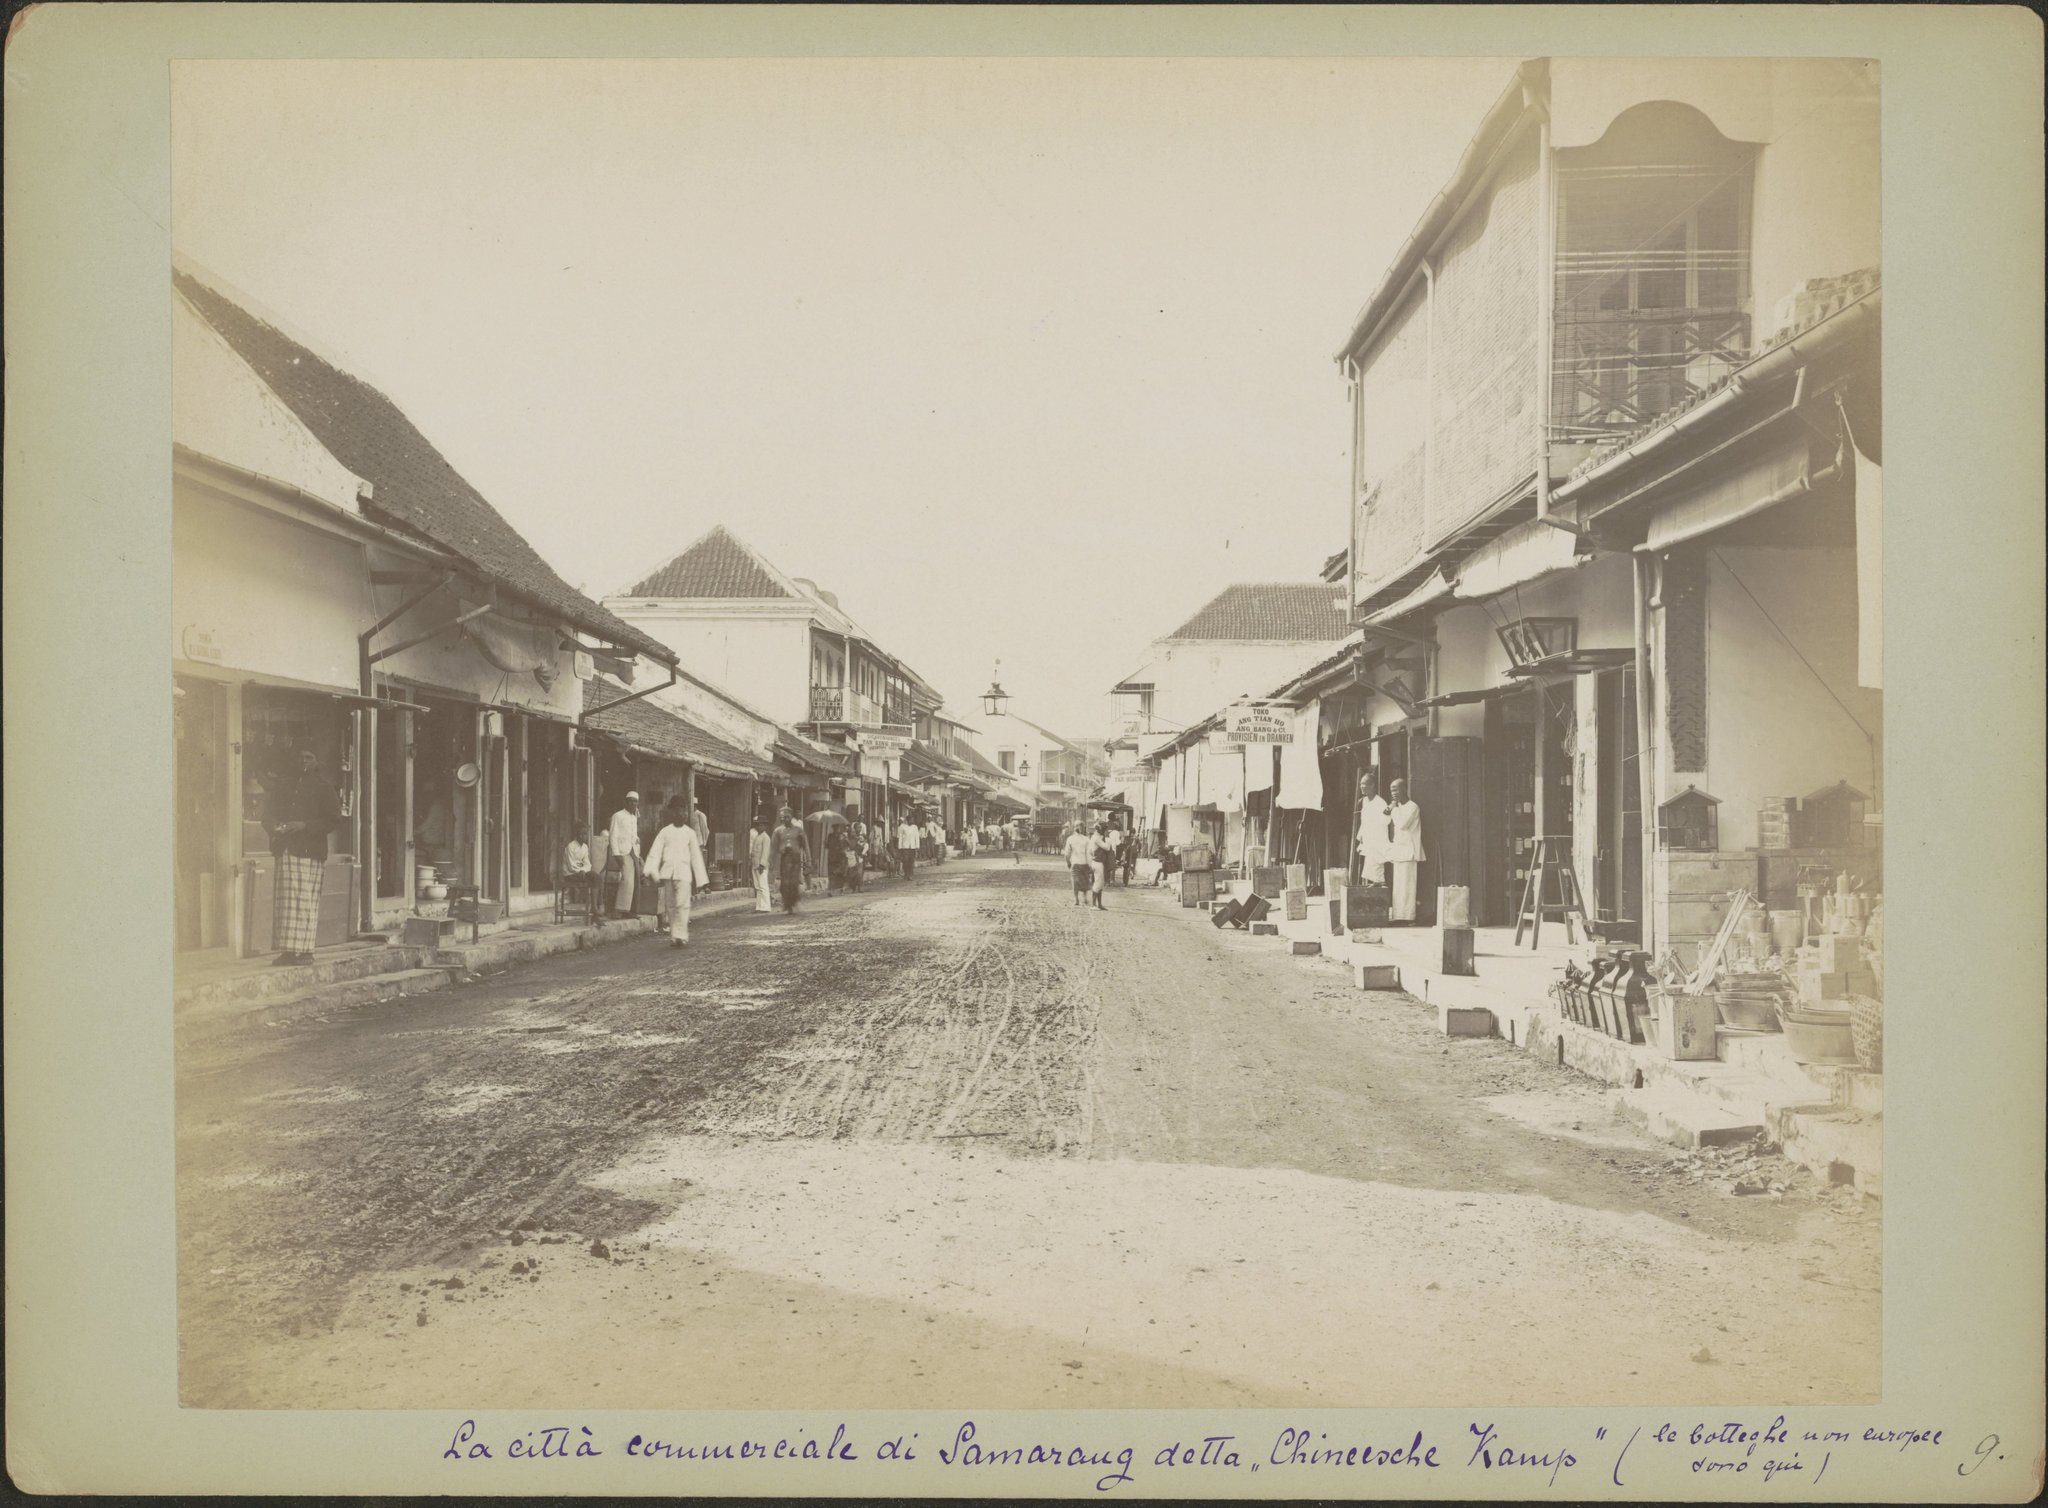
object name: album leaf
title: Straatgezicht in het Chinese kamp te Semarang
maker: Anonymous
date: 1870-1910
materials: cardboard, paper, photographic support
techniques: albumen print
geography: semarang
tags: shop, store, street (+ city(-scape) with figures, staffage)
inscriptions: inscription: ‘Chineesche kamp te Semarang’, inscription: ‘Collezione Maria van Maanen Via Boncompagni 93 Roma’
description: Onderdeel van Reisalbum met foto's van bezienswaardigheden in Marseille, Port Said, Aden, Bombay, Colombo, Singapore en Nederlands-Indië.